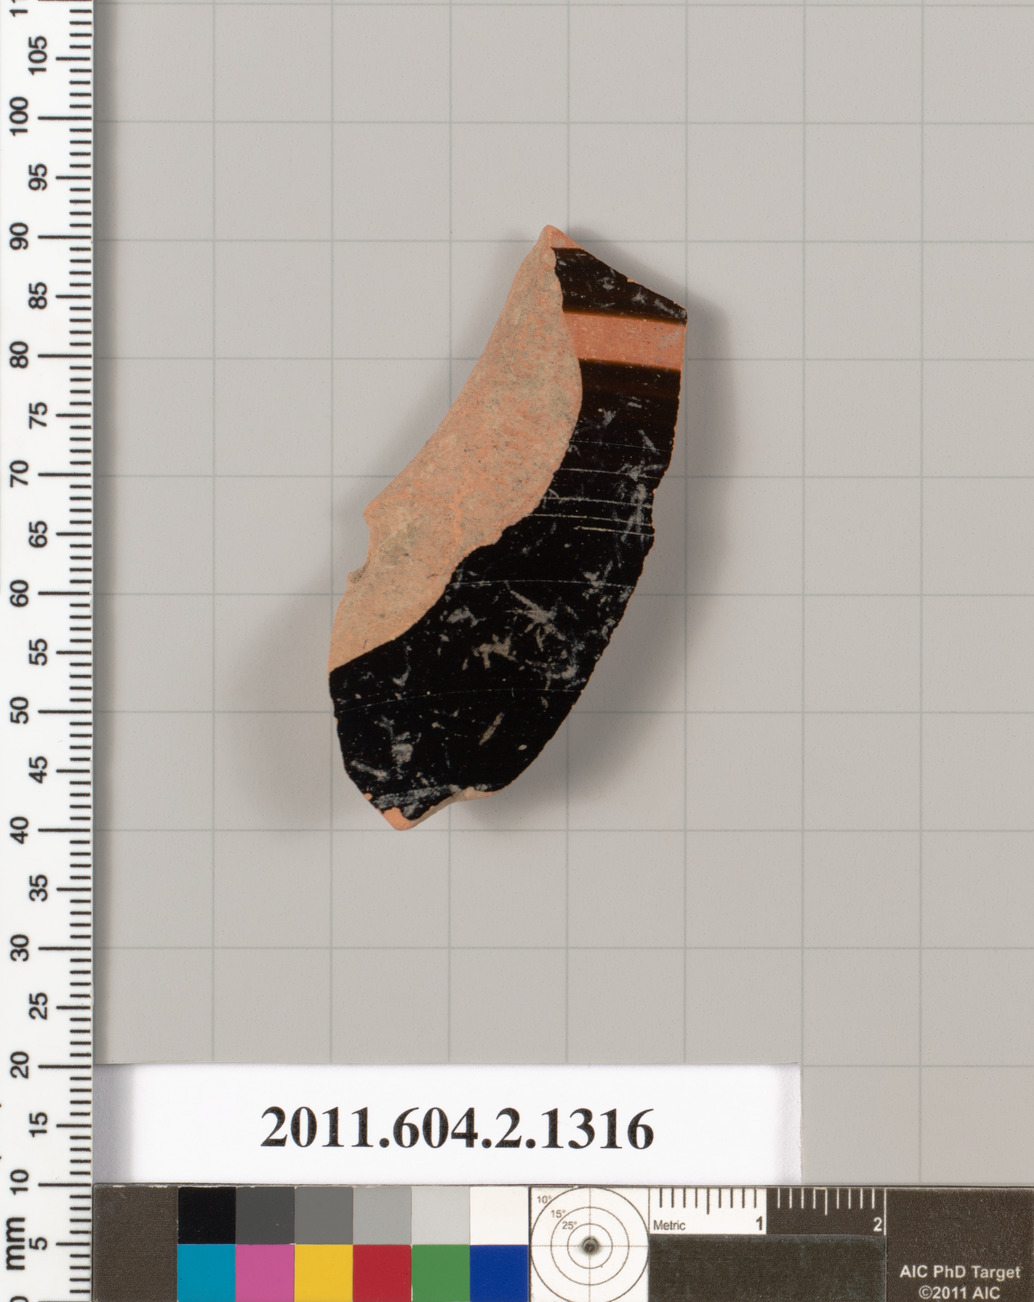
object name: skyphos fragment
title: Terracotta fragment of a skyphos (deep drinking cup)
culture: greek, attic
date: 500-451 BCE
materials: terracotta